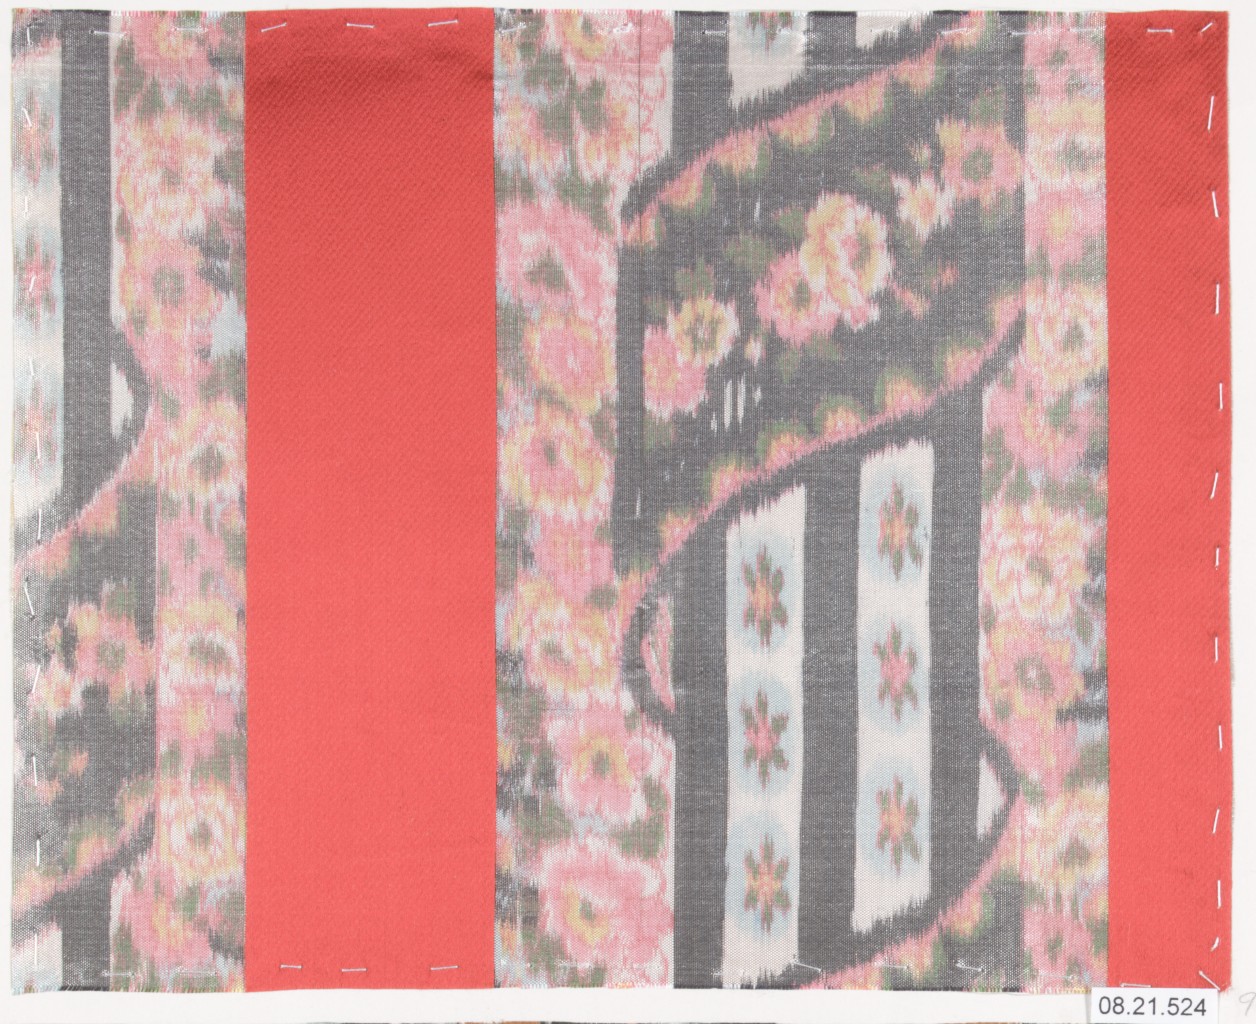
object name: textile sample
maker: Anonymous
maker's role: designer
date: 1900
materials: silk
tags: flowers